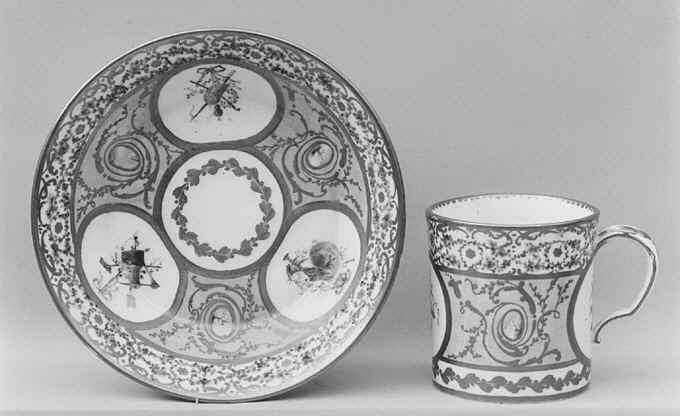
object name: cup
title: Cup (gobelet litron)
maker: sèvres manufactory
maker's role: manufactory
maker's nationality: french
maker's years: 1740-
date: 1783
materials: soft paste porcelain